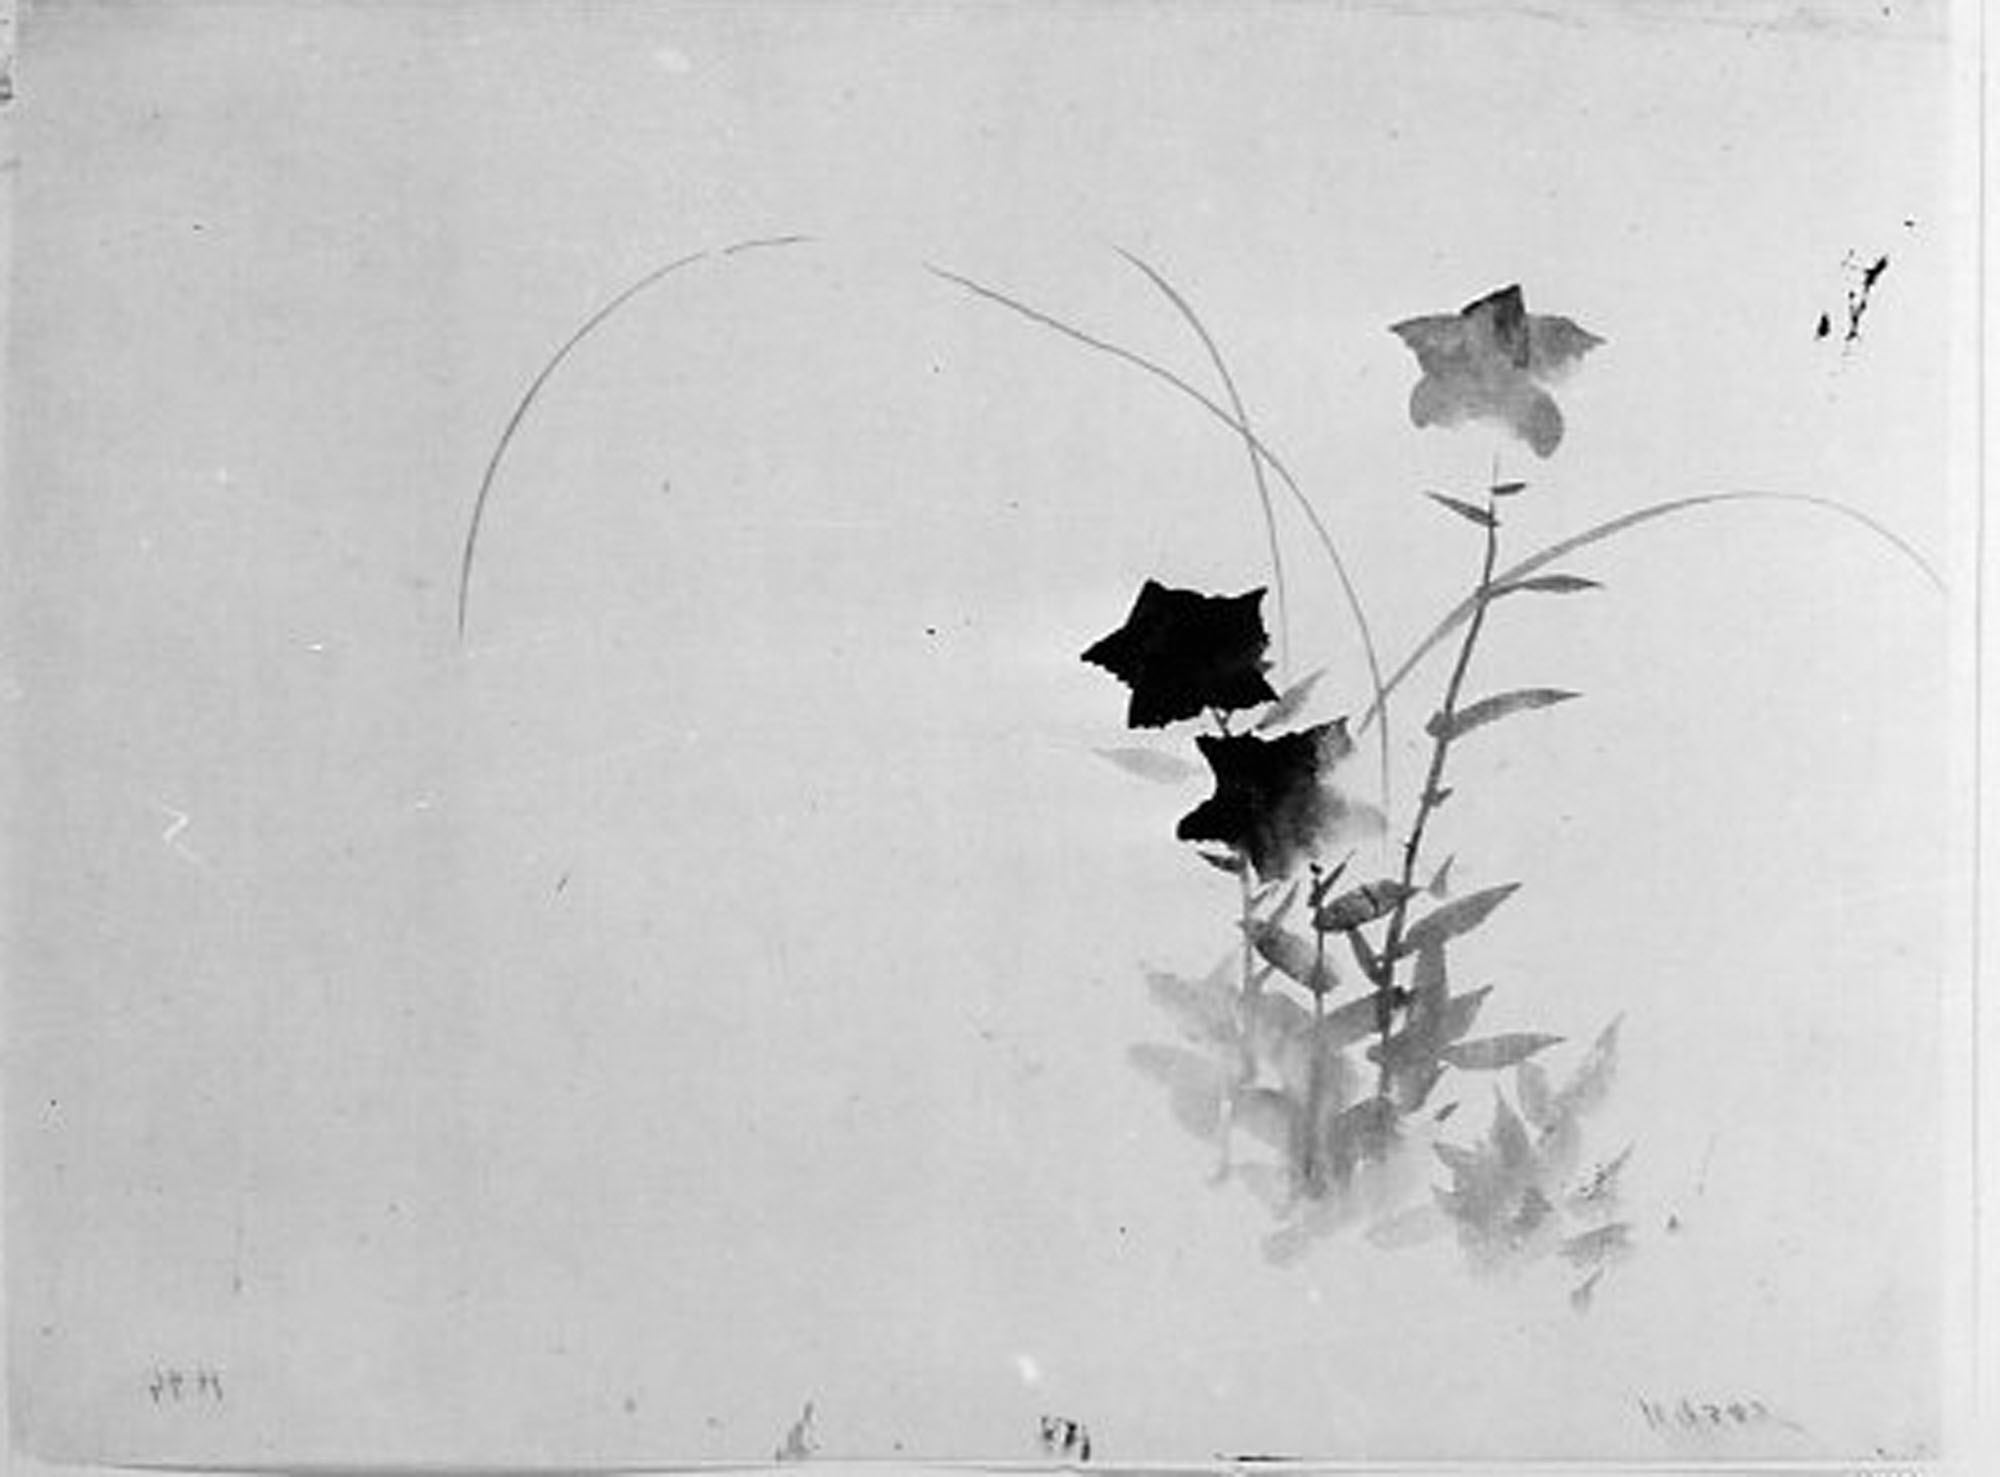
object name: painting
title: Bellflower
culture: japanese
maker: hokusai school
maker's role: artist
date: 1801-1900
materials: ink, paper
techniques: painting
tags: leaves